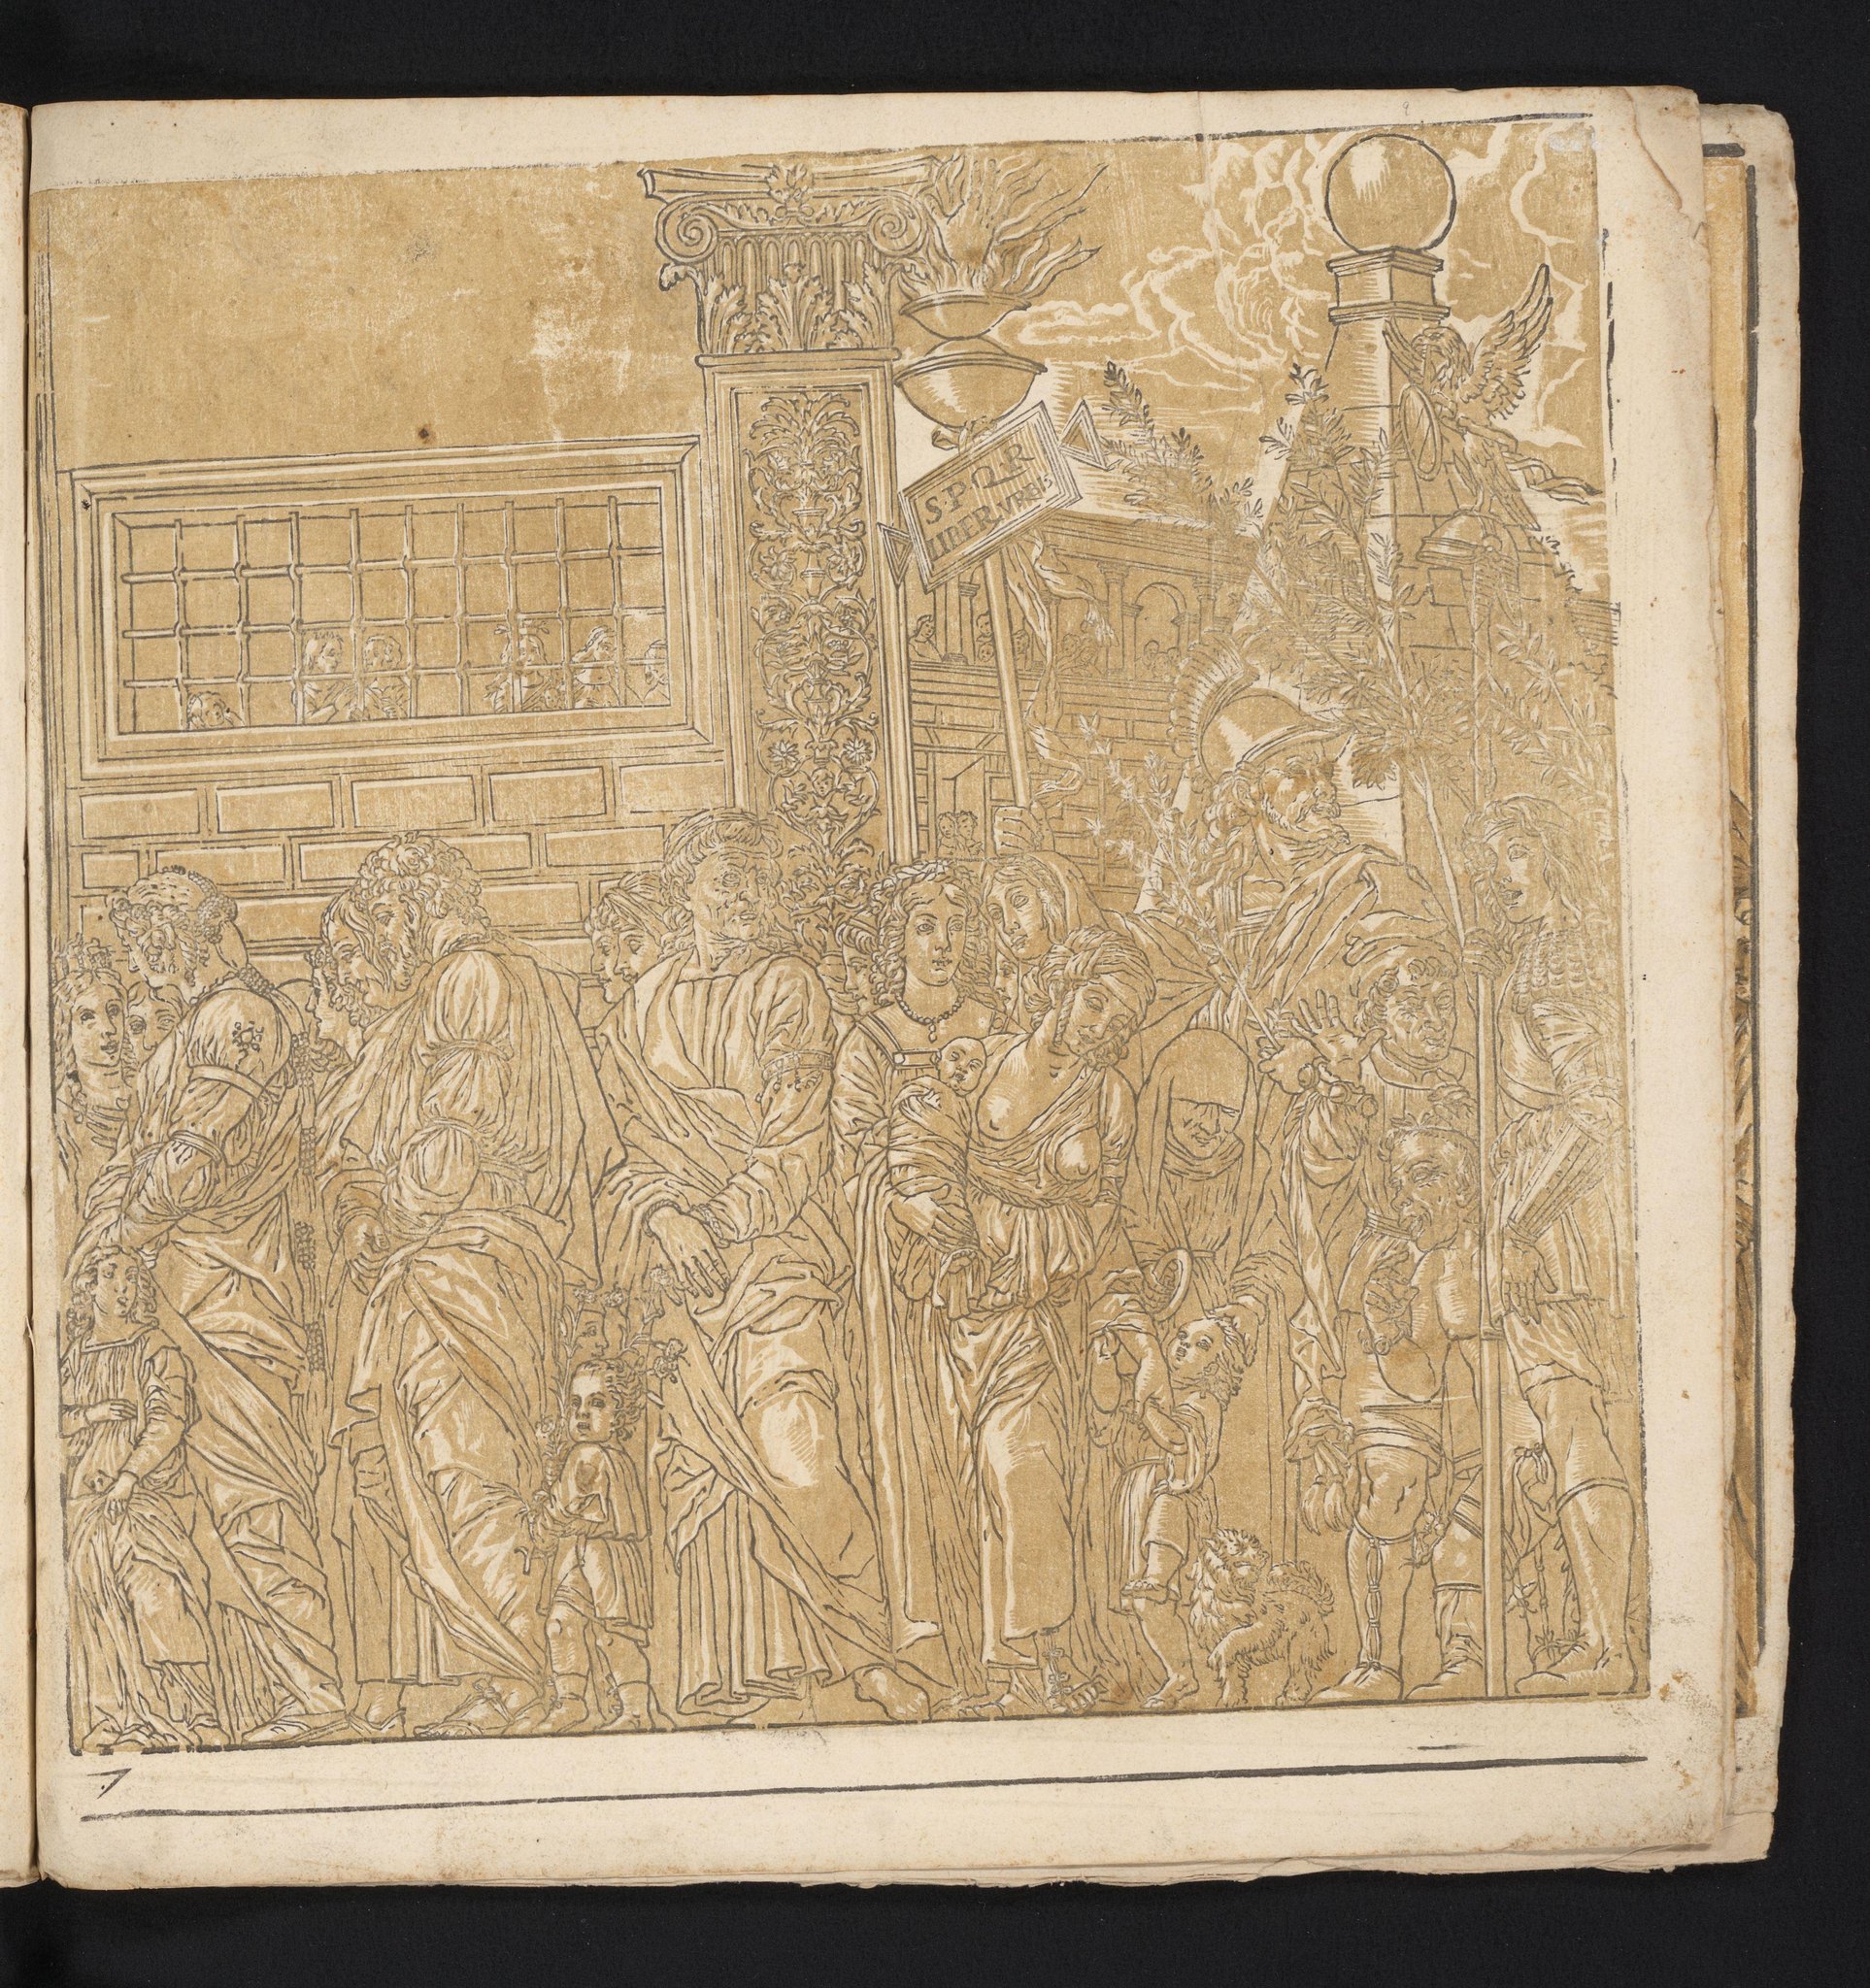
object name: print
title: Triomftocht van Julius Caesar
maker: andrea andreani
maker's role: print maker, printer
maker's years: 1558-1629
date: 1599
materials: paper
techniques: woodcut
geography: mantua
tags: torch, triumph of caesar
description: Genummerd linksonder: 7. De prent maakt deel uit van een album.